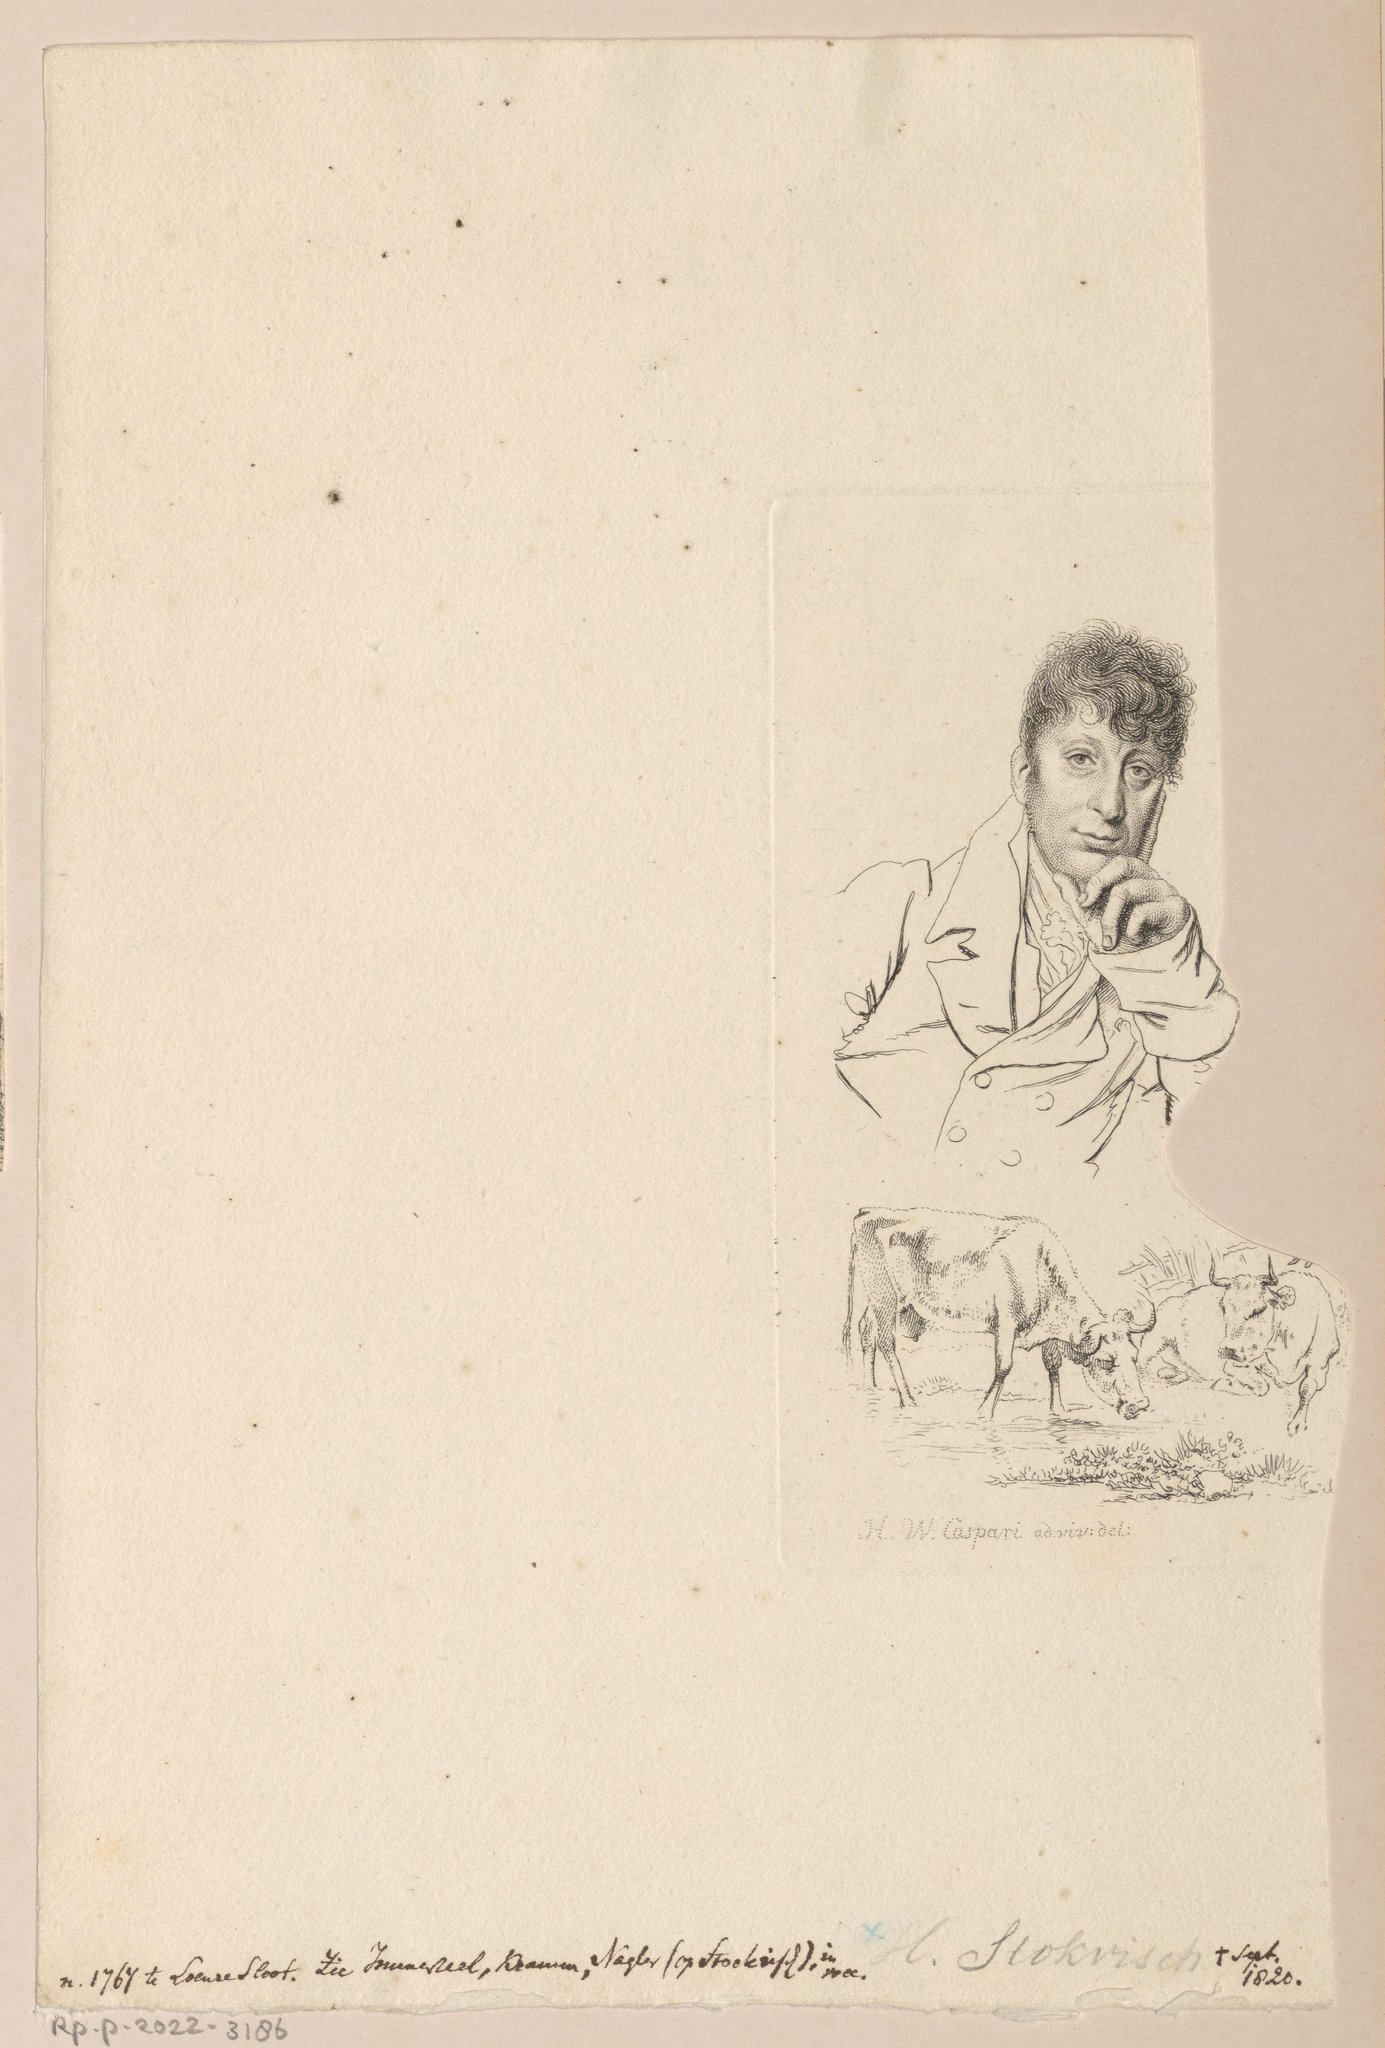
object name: print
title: Portret van Hendrik Stokvisch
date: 1803-1811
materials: paper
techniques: etching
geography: amsterdam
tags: amsterdam, painter, draughtsman, hendrik stokvisch, historical persons, portrait, self-portrait of artist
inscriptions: inscription: ‘n. 1767 te (...) + sept. / 1820.’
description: Serie voor het eerst uitgegeven door Jacob Ernst Marcus onder de titel Studiebeelden en Fragmenten. Amsterdam: ca.1816. Later heruitgegeven als: Studie-prentwerk/ Etudes gravées.